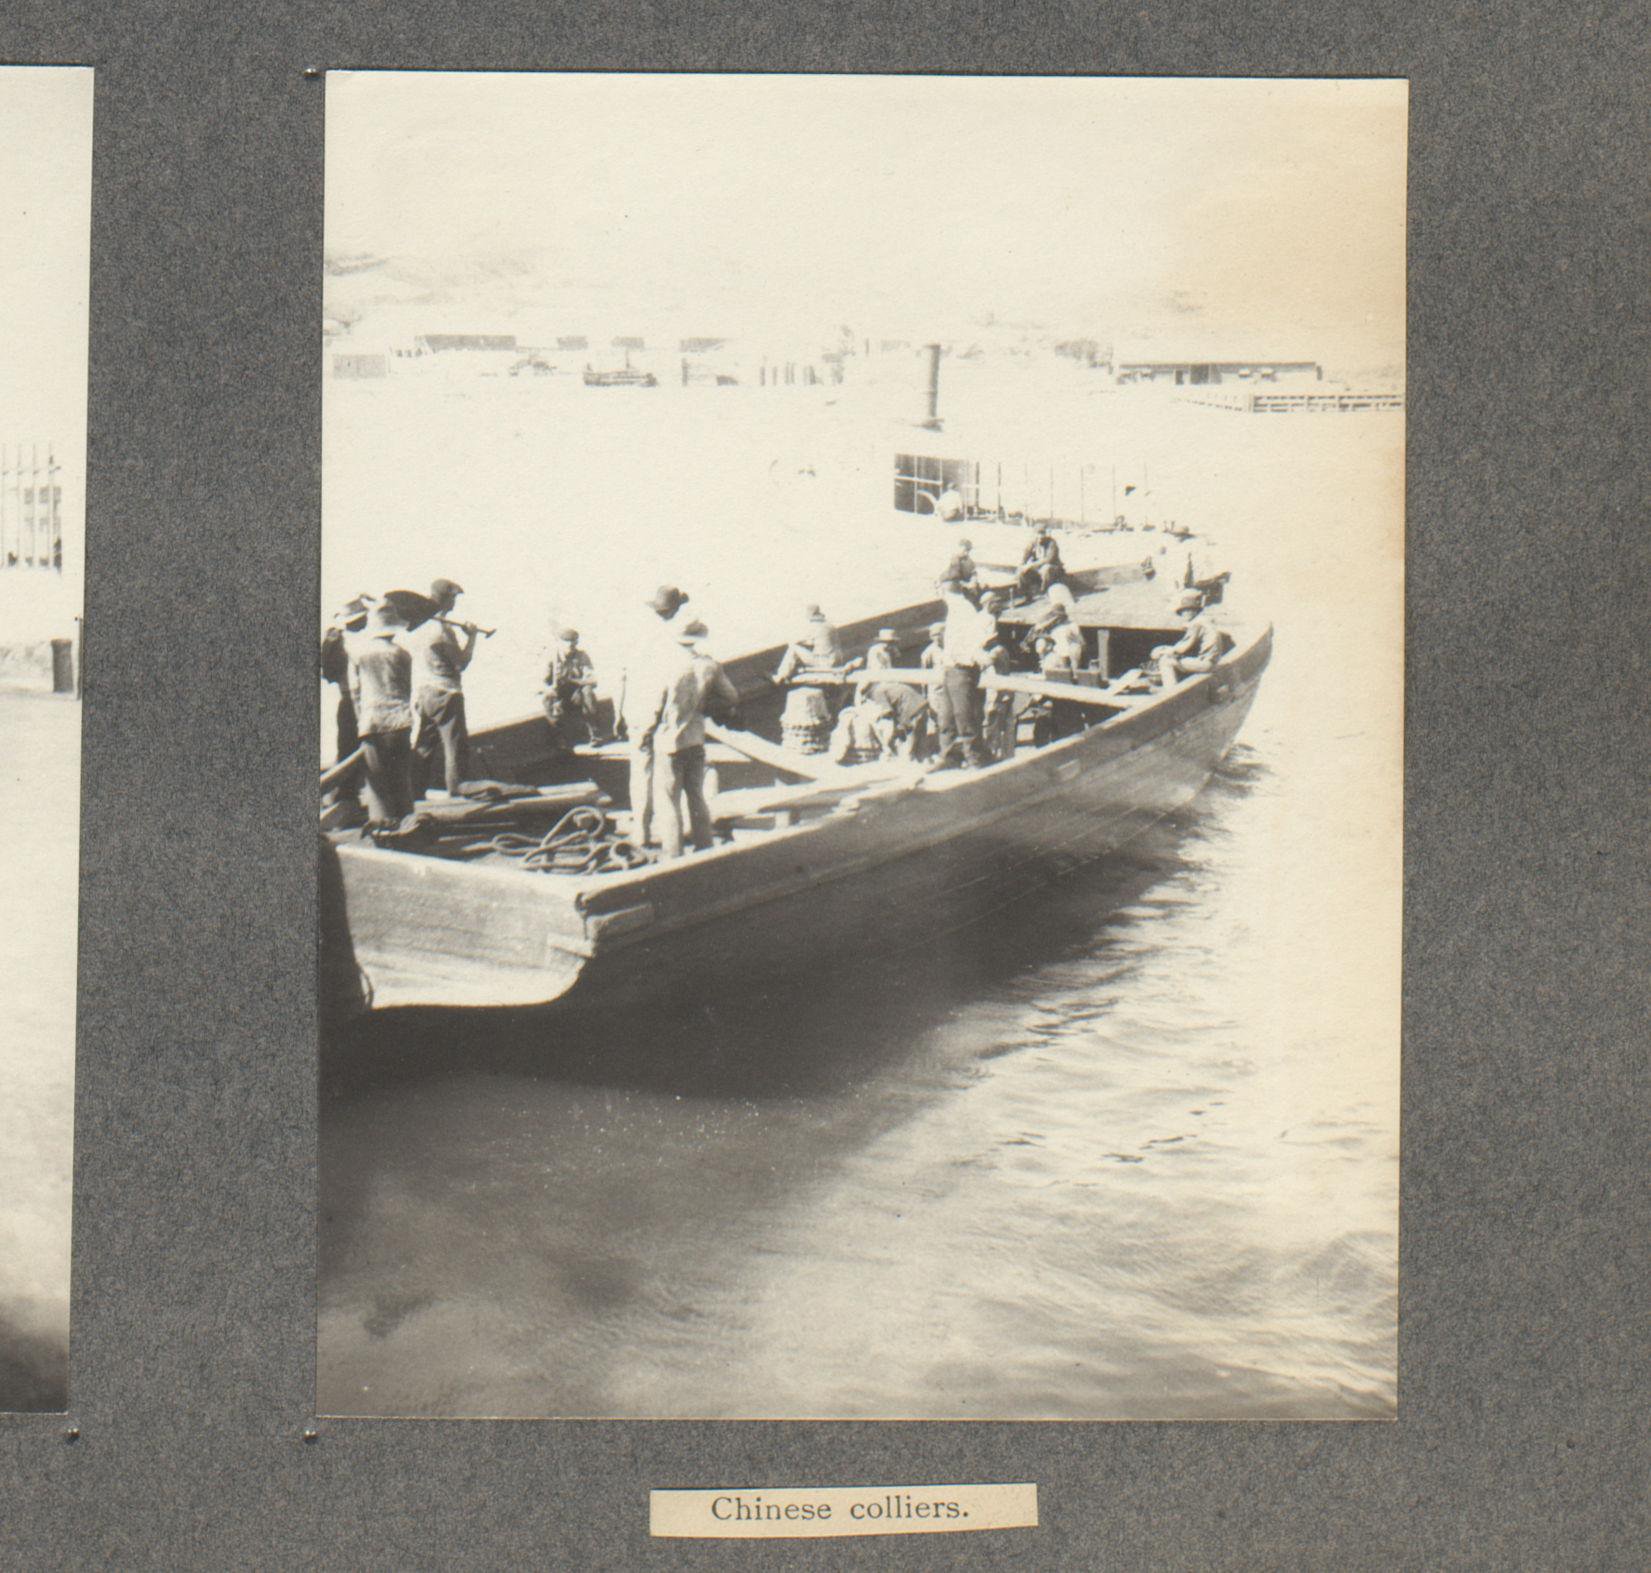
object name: photograph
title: Chinese colliers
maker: Anonymous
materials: paper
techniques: platinum process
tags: miner, ships (in general)